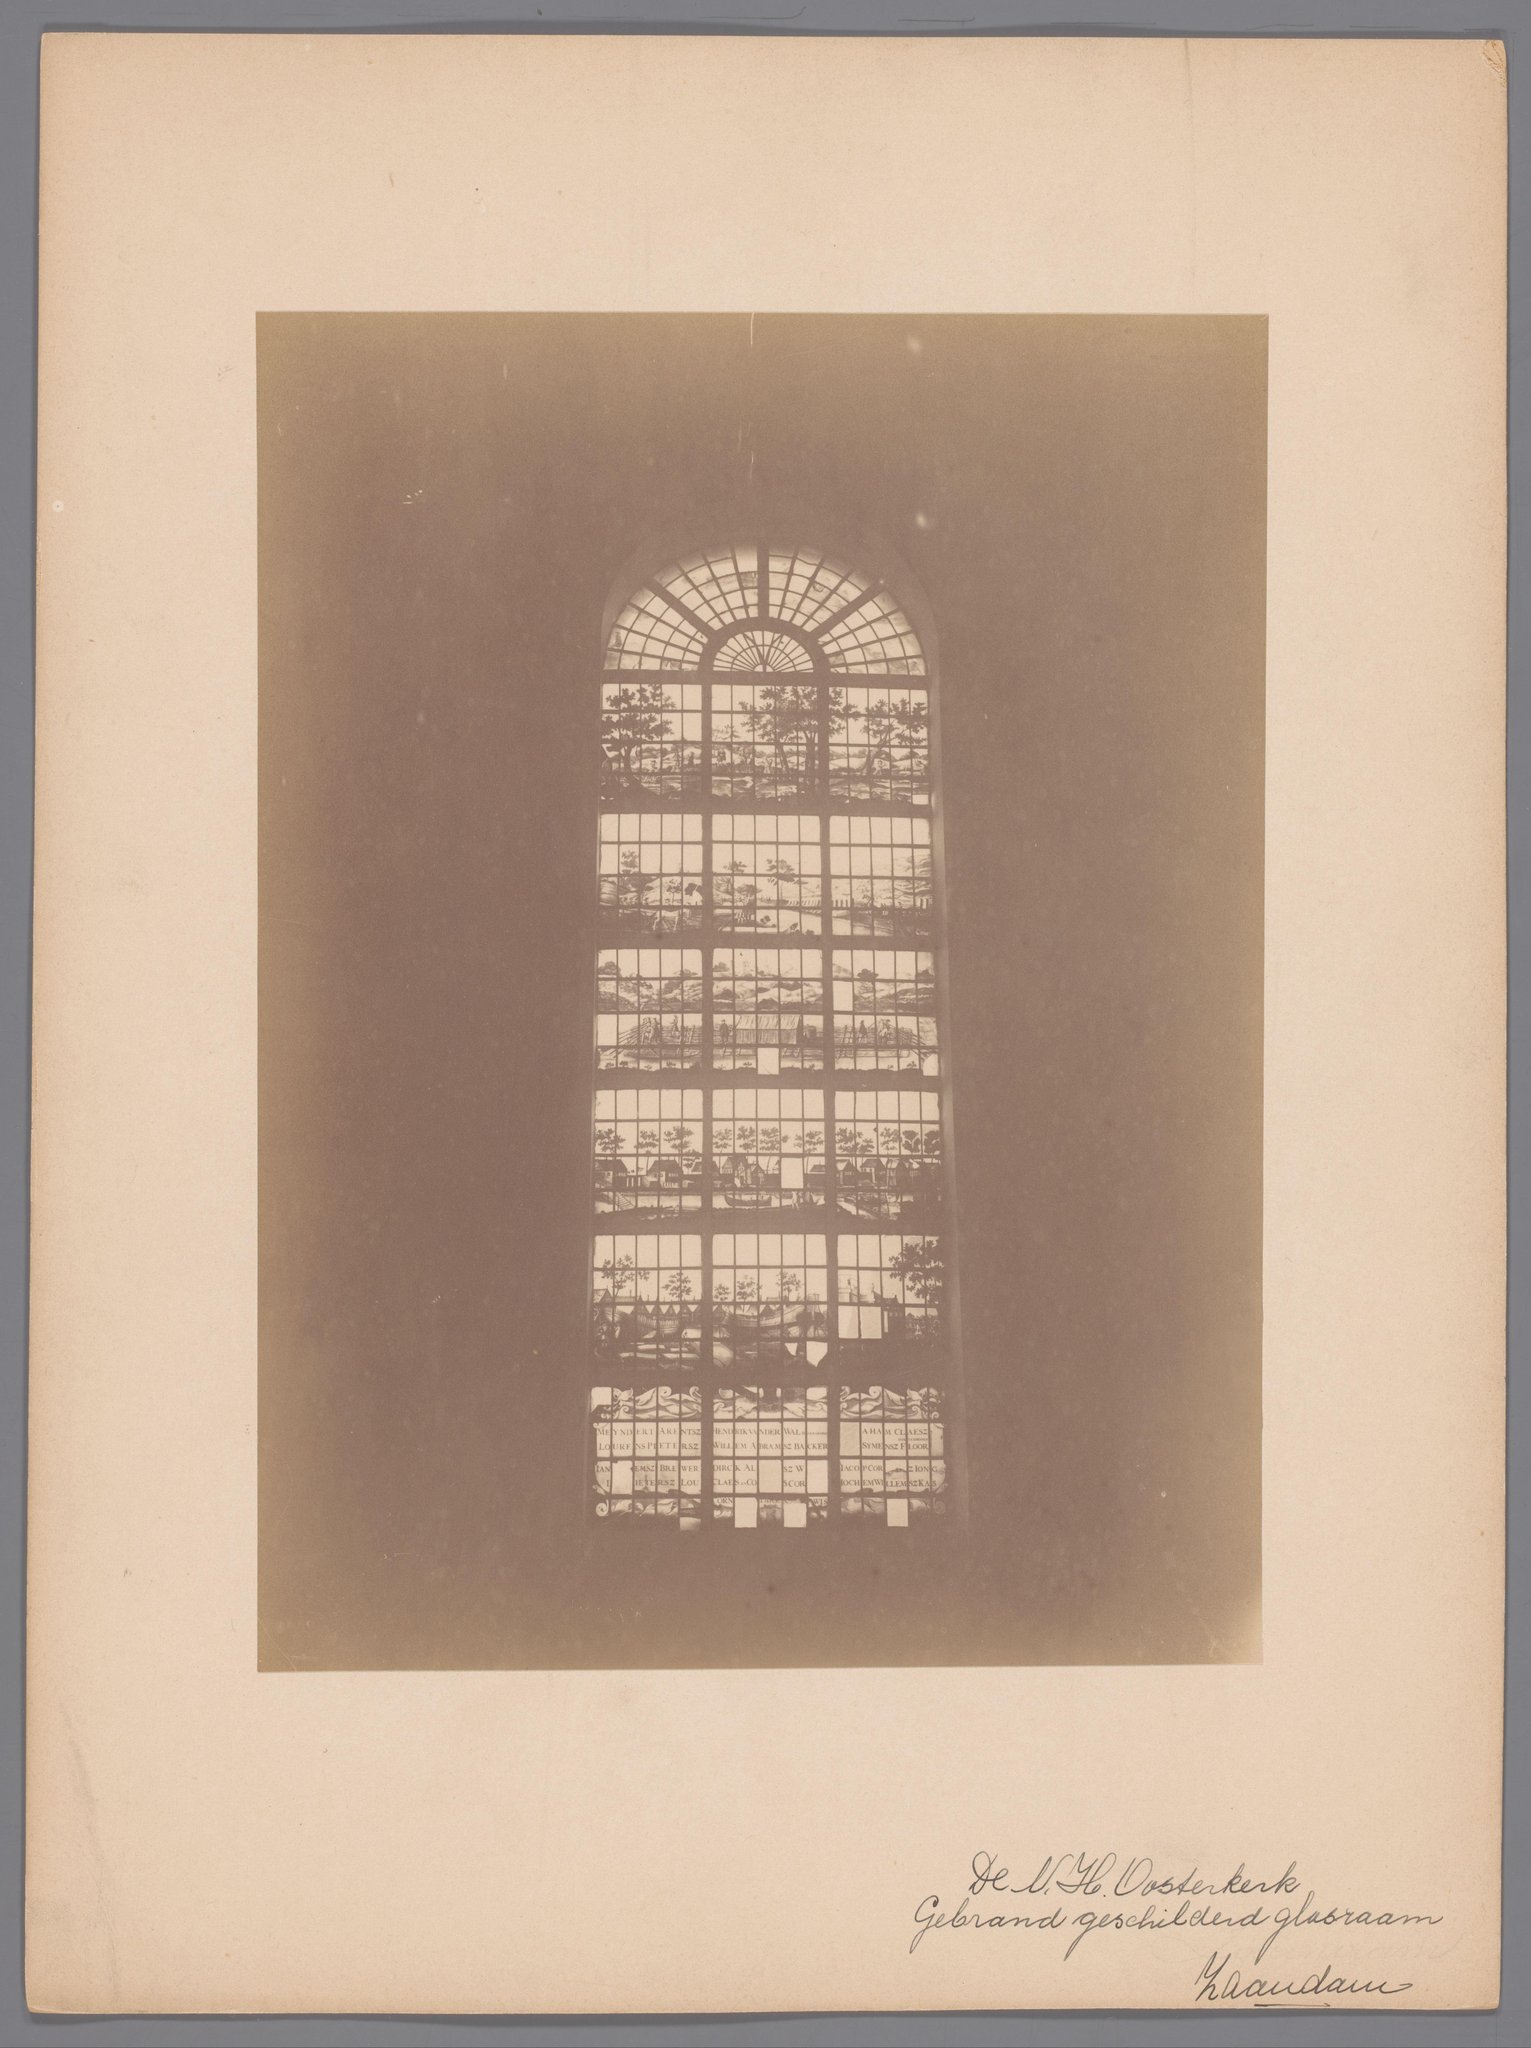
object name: photograph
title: Geschilderd raam in de Nederlands-hervormde Oosterkerk te Zaandam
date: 1890-1910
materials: cardboard, photographic support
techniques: albumen print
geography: oosterkerk zaandam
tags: church-window, e.g. rose-window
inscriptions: annotation: ‘Gebrand geschilderd glasraam in de Oosterkerk te Zaandam’, annotation: ‘De N.H. Oosterkerk/ gebrand geschilderd glasraam/ Zaandam’